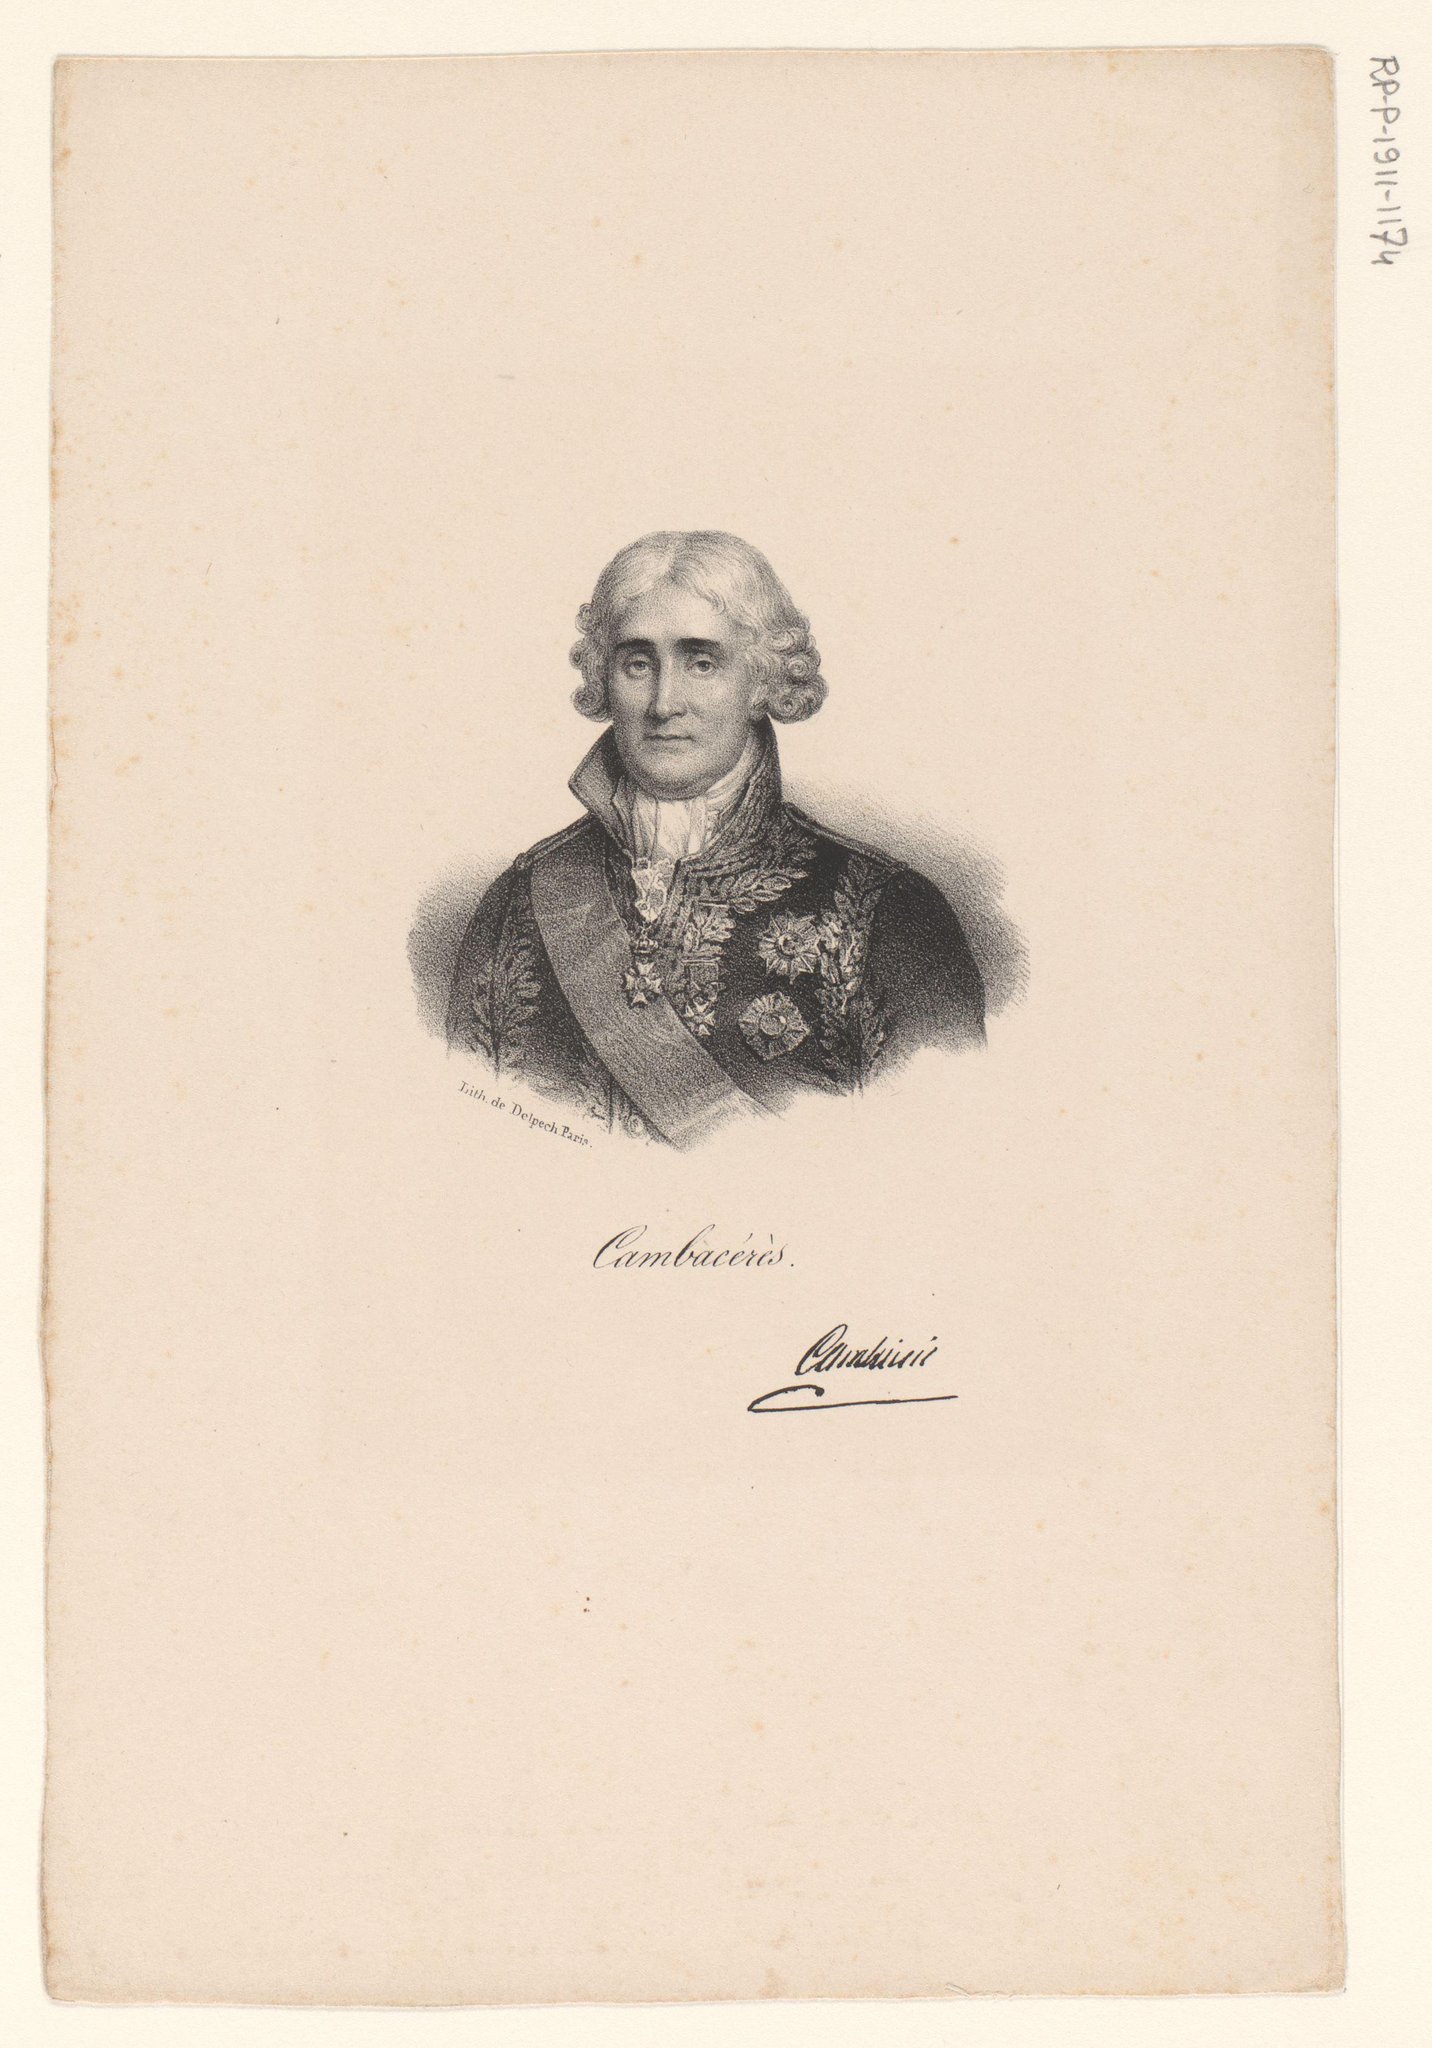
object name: print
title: Cambacérès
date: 1818-1842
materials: paper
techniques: lithograph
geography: paris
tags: paris, politician, historical persons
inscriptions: collector's mark: Lugt 2228a